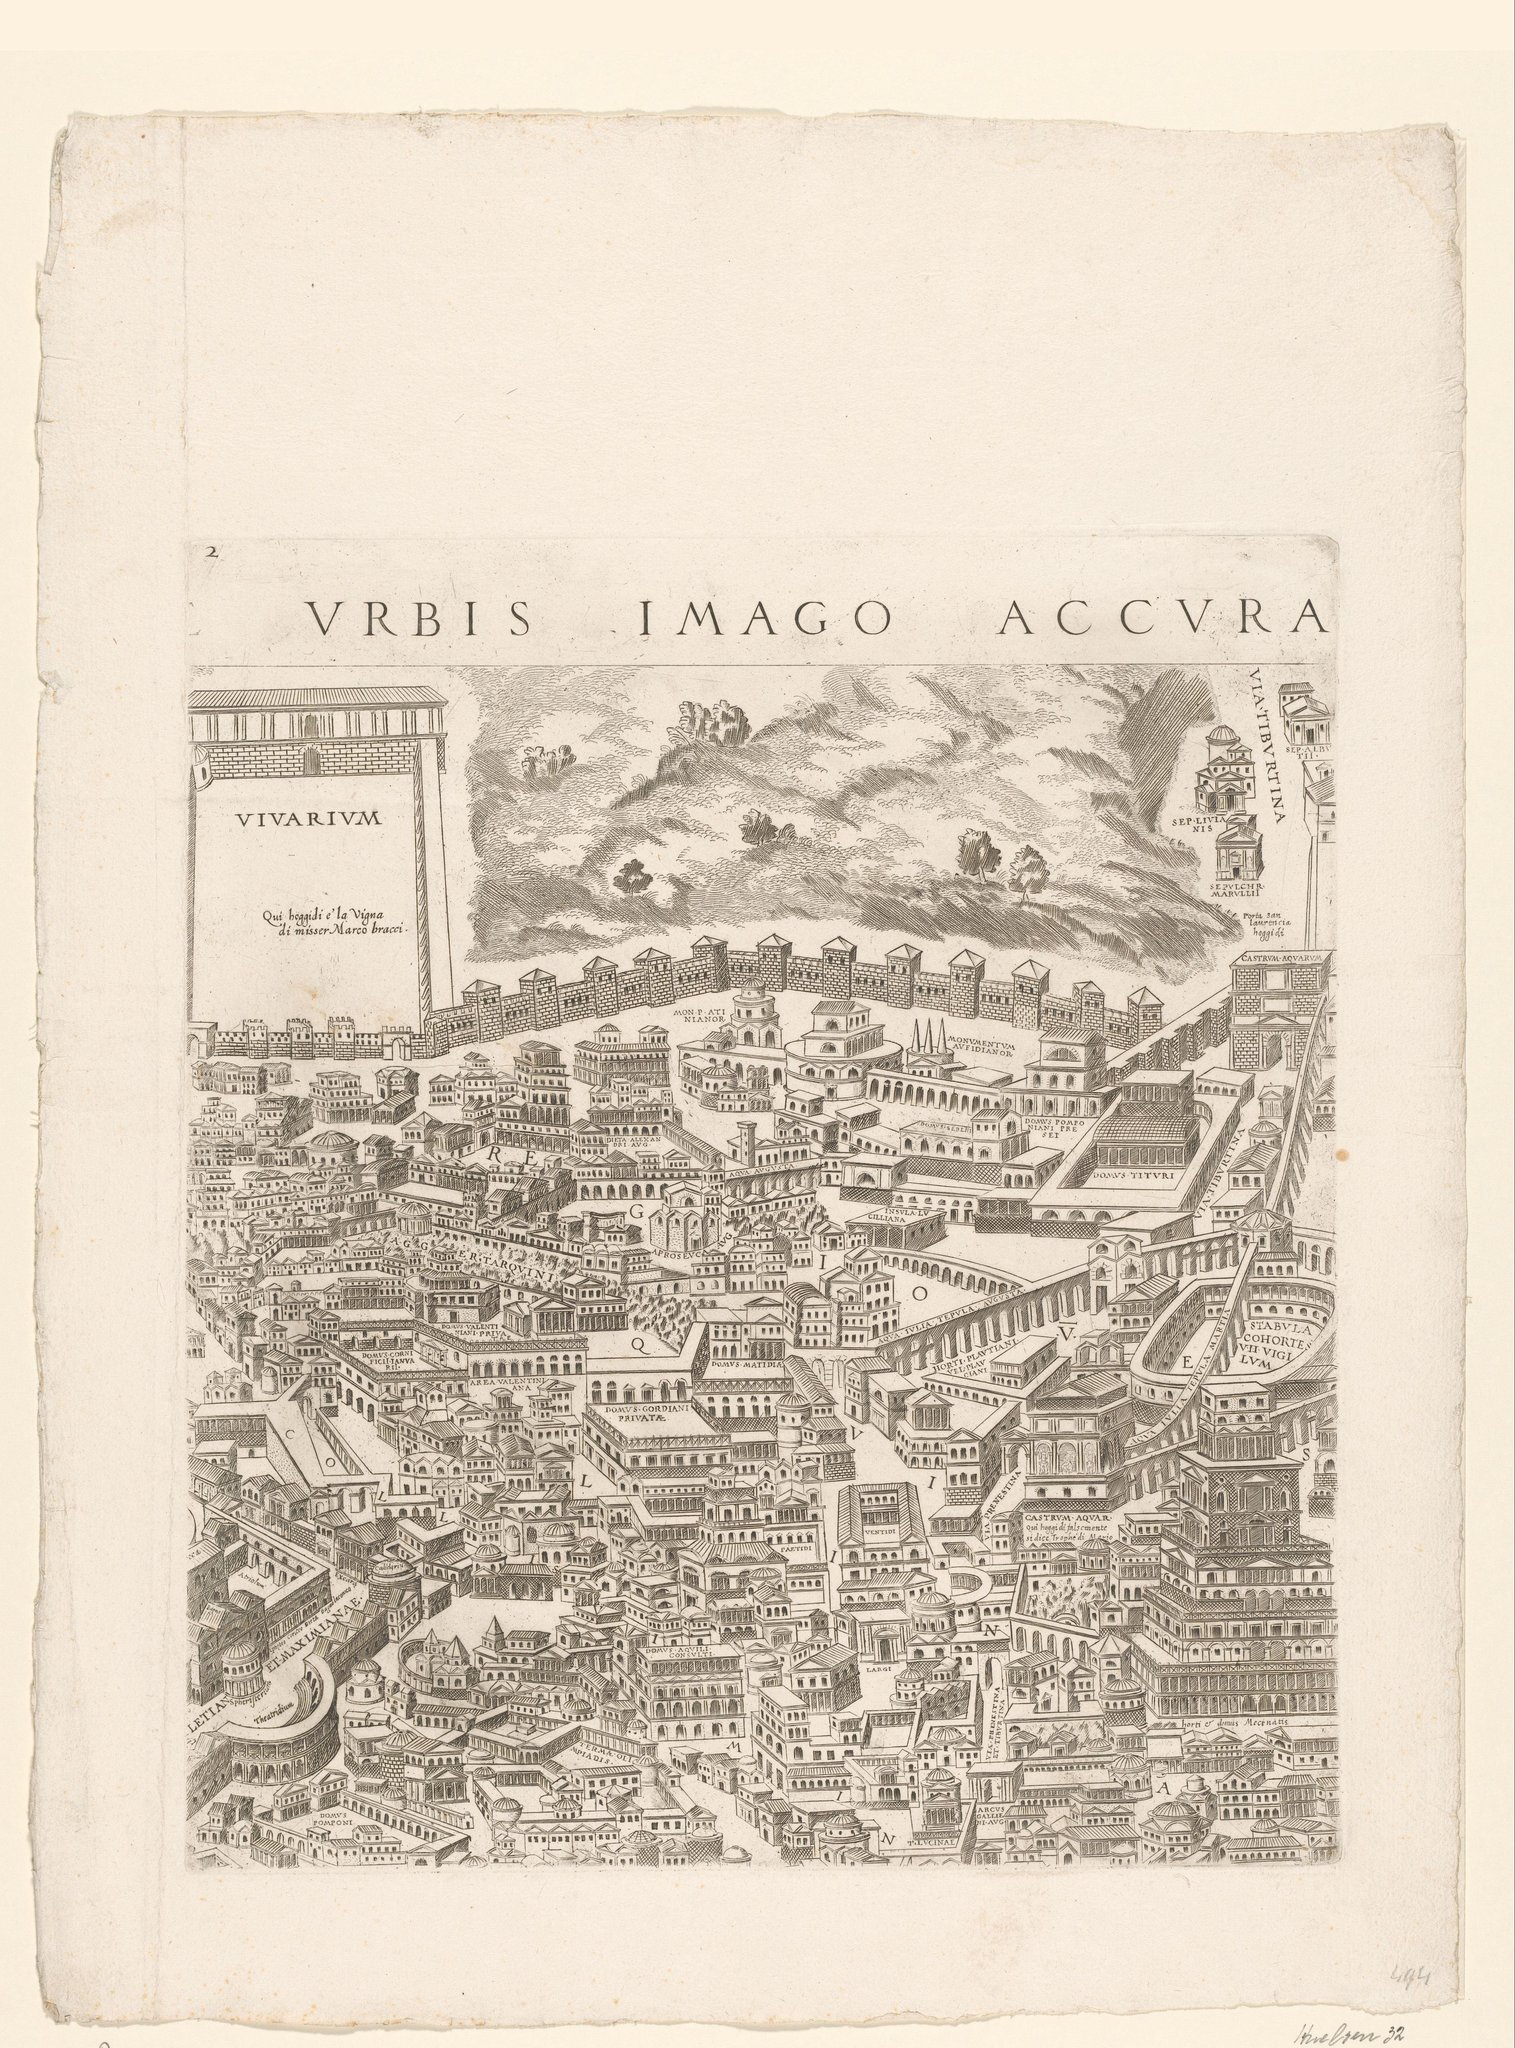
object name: print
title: Anteiquae urbis imago, accuratissime ex vetusteis monumenteis formata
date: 1773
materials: paper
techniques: engraving, etching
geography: rome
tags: maps of cities, rome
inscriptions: collector's mark: Lugt 2228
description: Tweede deel van een plattegrond van Rome in de Romeinse tijd, in vogelvluchtperspectief, bestaande uit twaalf delen. Linksboven genummerd: 2.